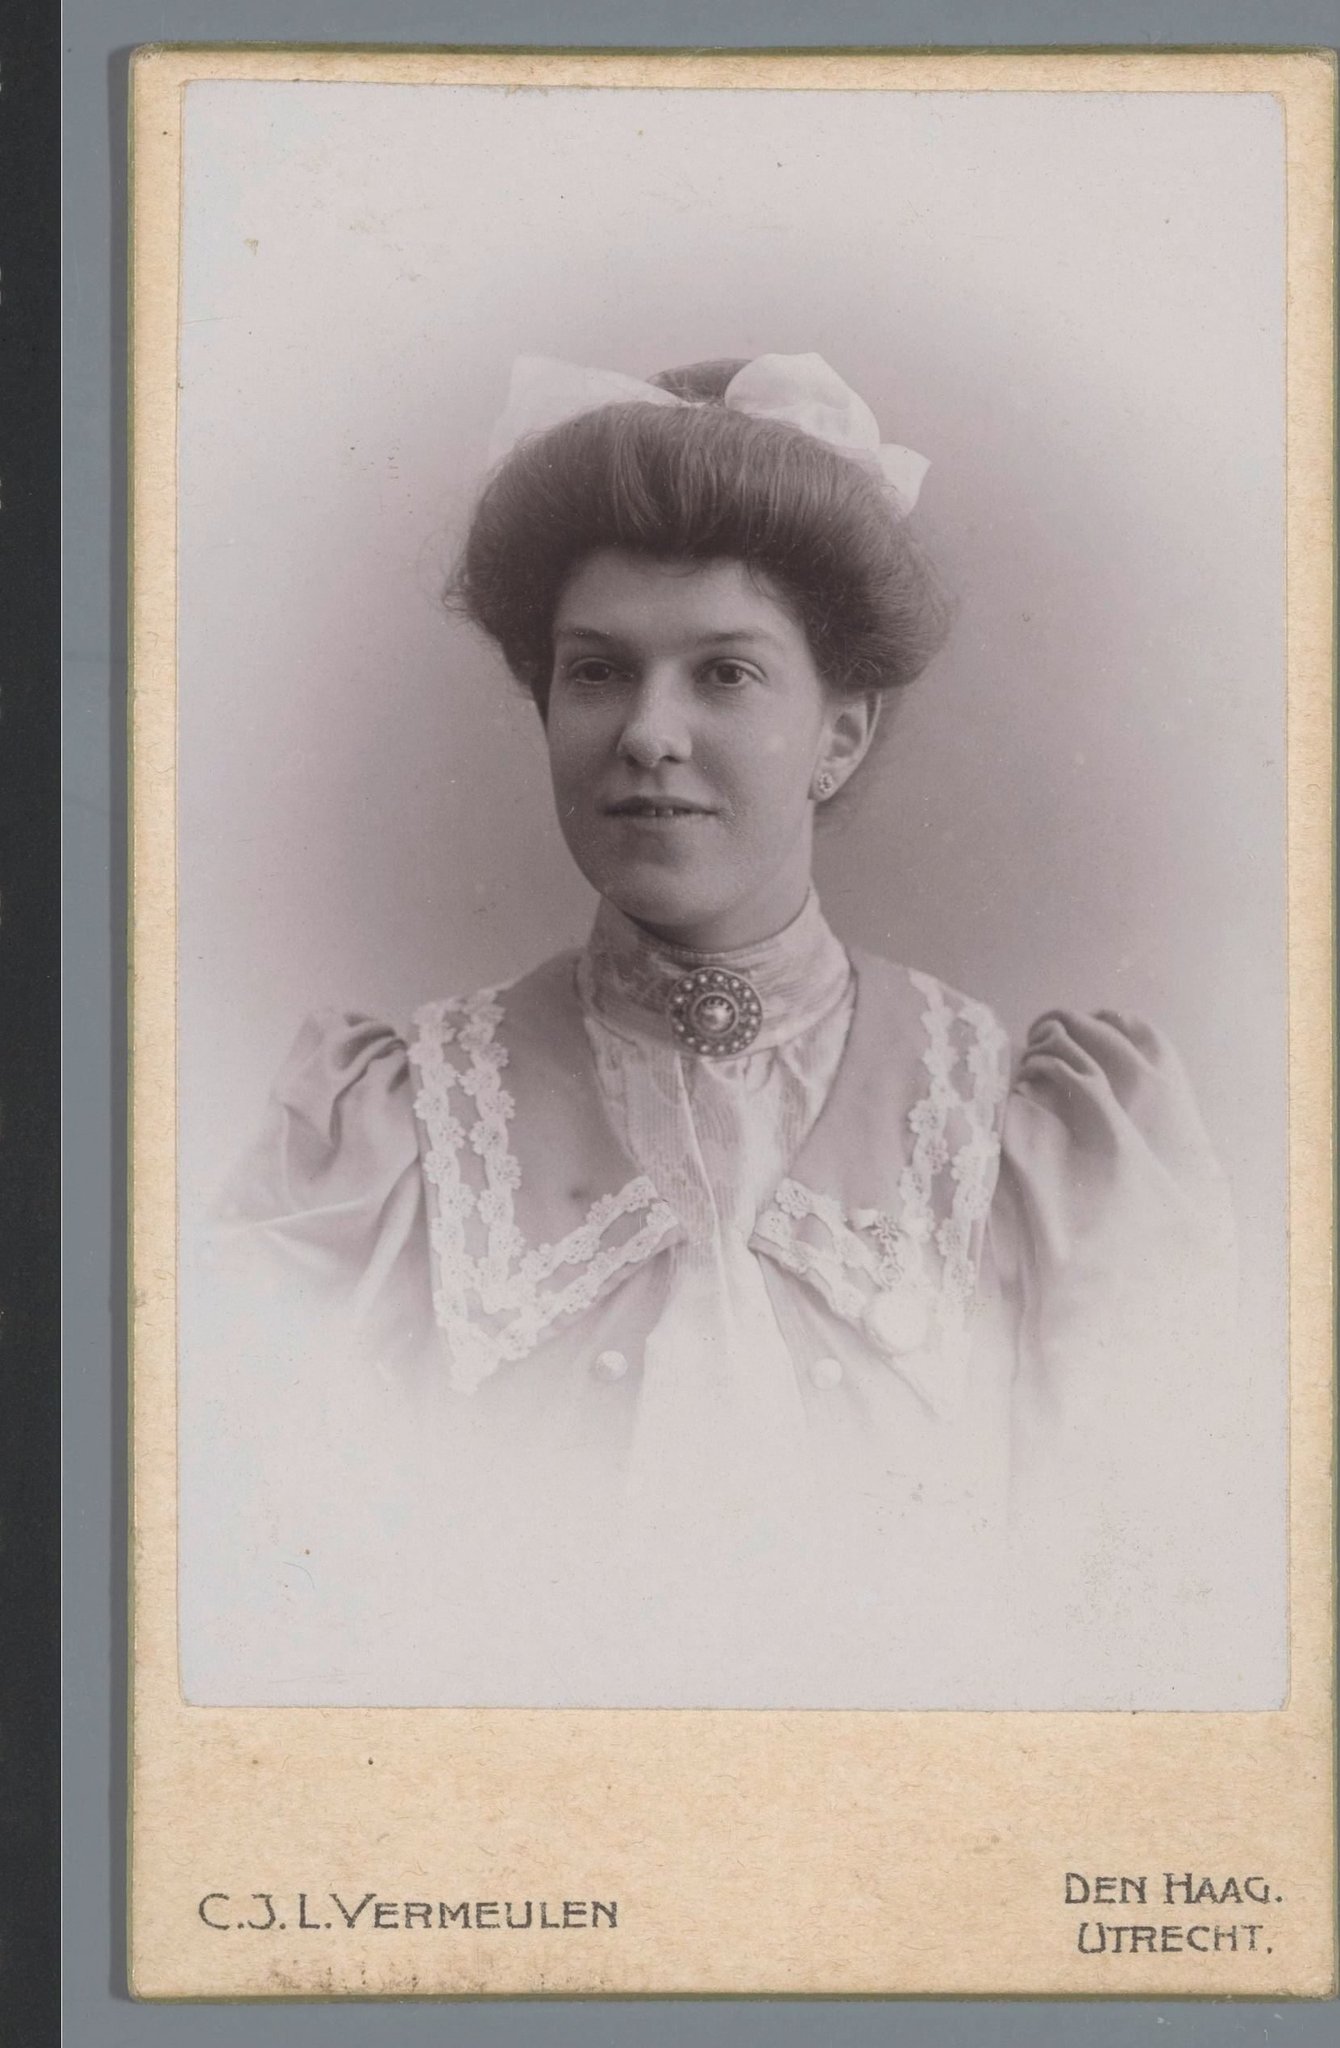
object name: carte de visite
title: Portret van een onbekende vrouw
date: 1900-1920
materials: cardboard, photographic support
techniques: collodion silver print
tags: historical persons - bb - woman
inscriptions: inscription: ‘C. J. L. VERMEULEN/ ATELIER/ VOOR/ MODERNE/ FOTOGRAFIE/ DEN HAAG/ TOUSSAINTKADE 11/ TELEFOON 1873/ UTRECHT/ NIEUWEGRACHT 50/ TELEFOON 750.’